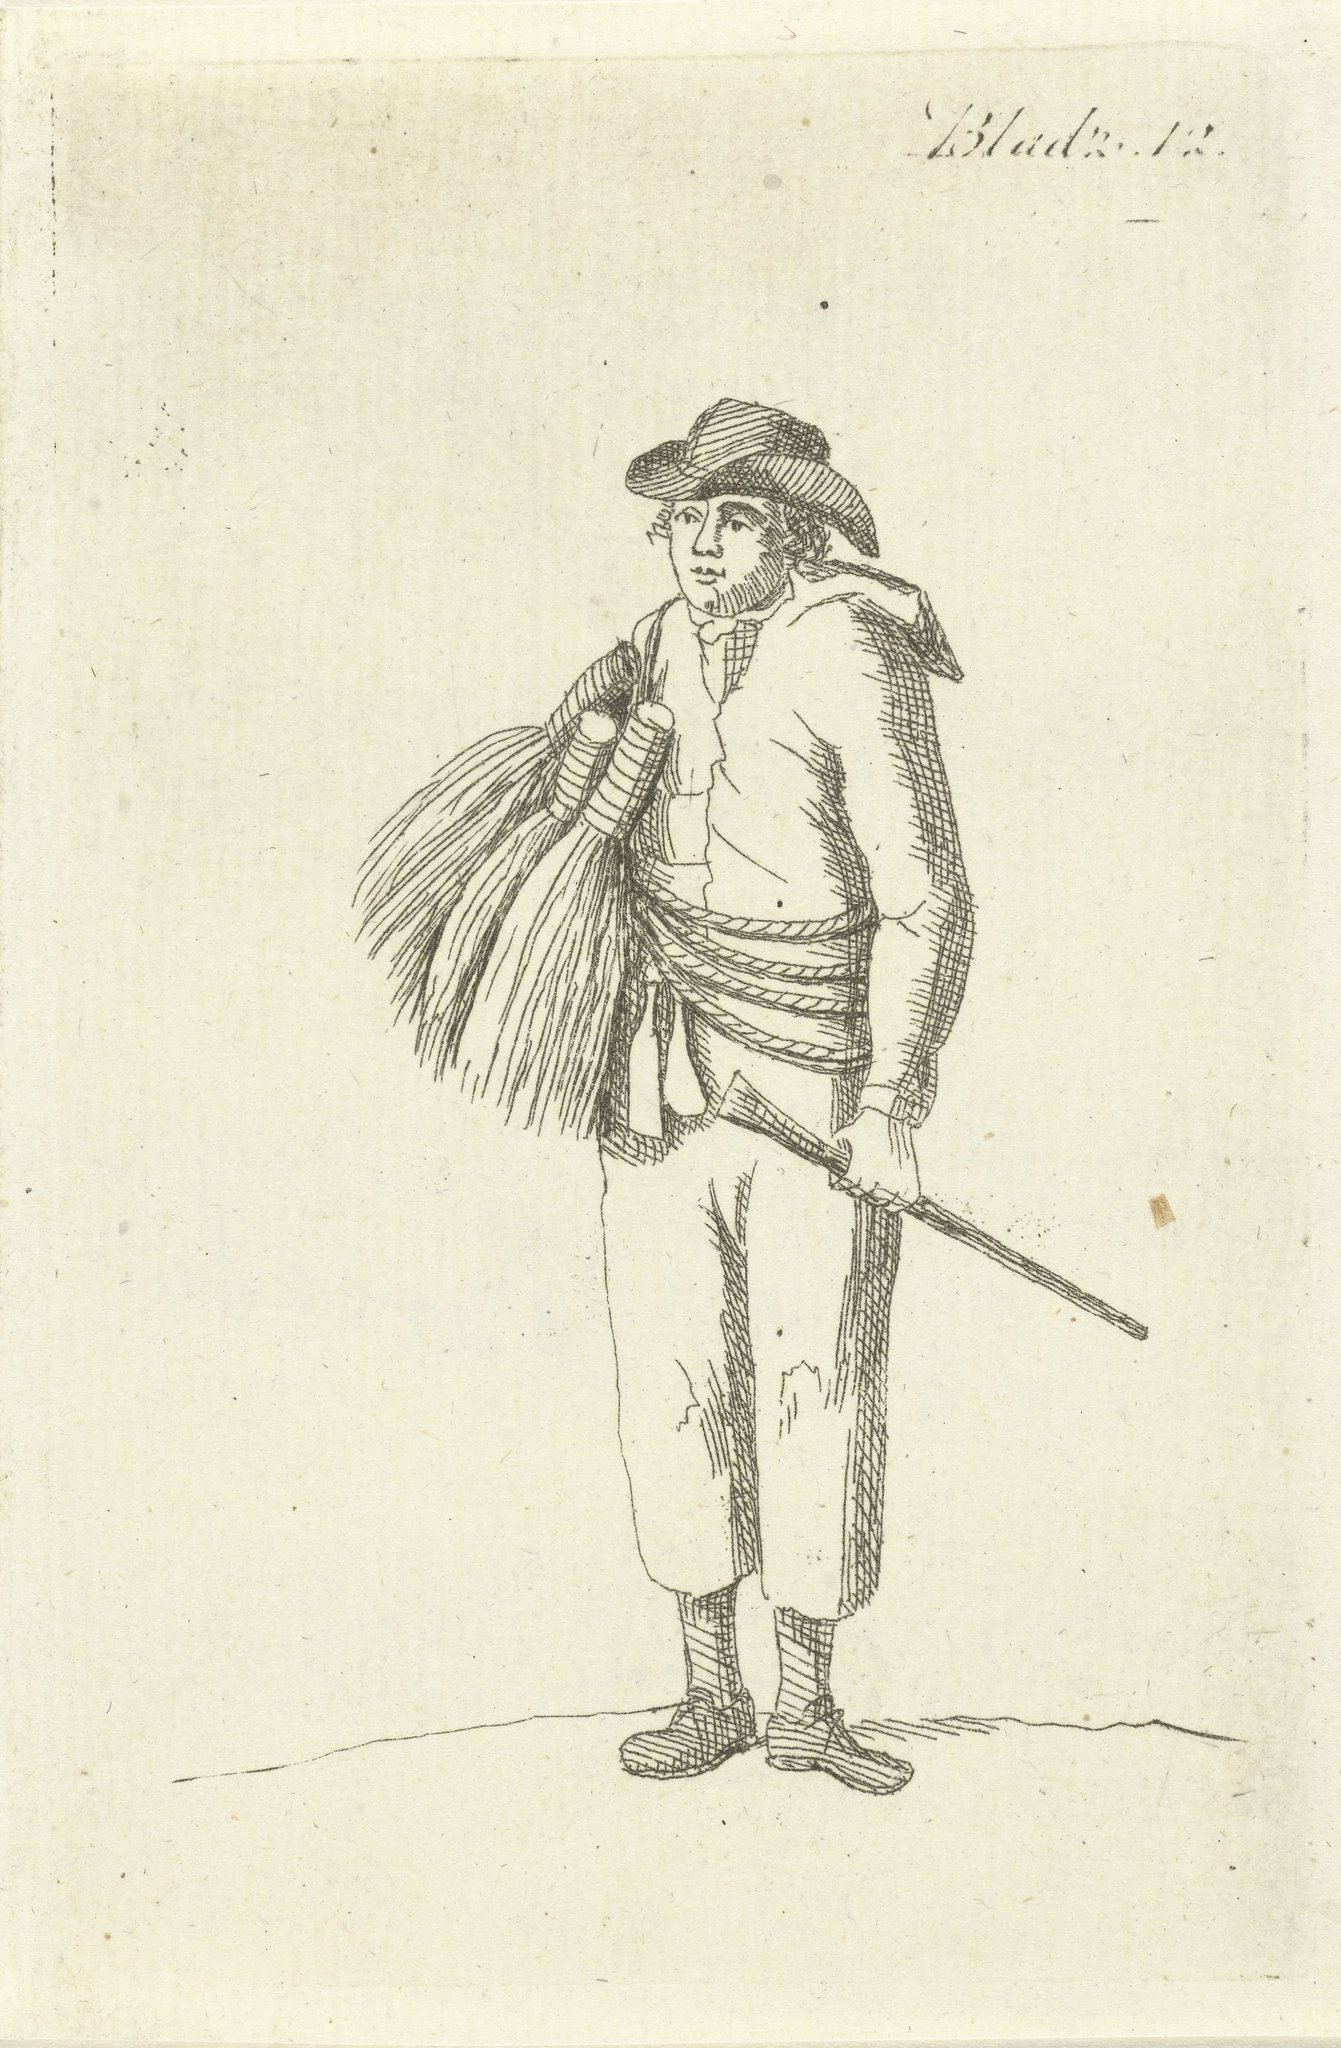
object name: print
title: Staande man met handbezems over zijn schouder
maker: anthonie van den bos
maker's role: draughtsman, print maker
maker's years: 1763-1838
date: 1778-1838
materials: paper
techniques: etching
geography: netherlands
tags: standing figure (canon, proportions)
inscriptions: collector's mark: Lugt 2228